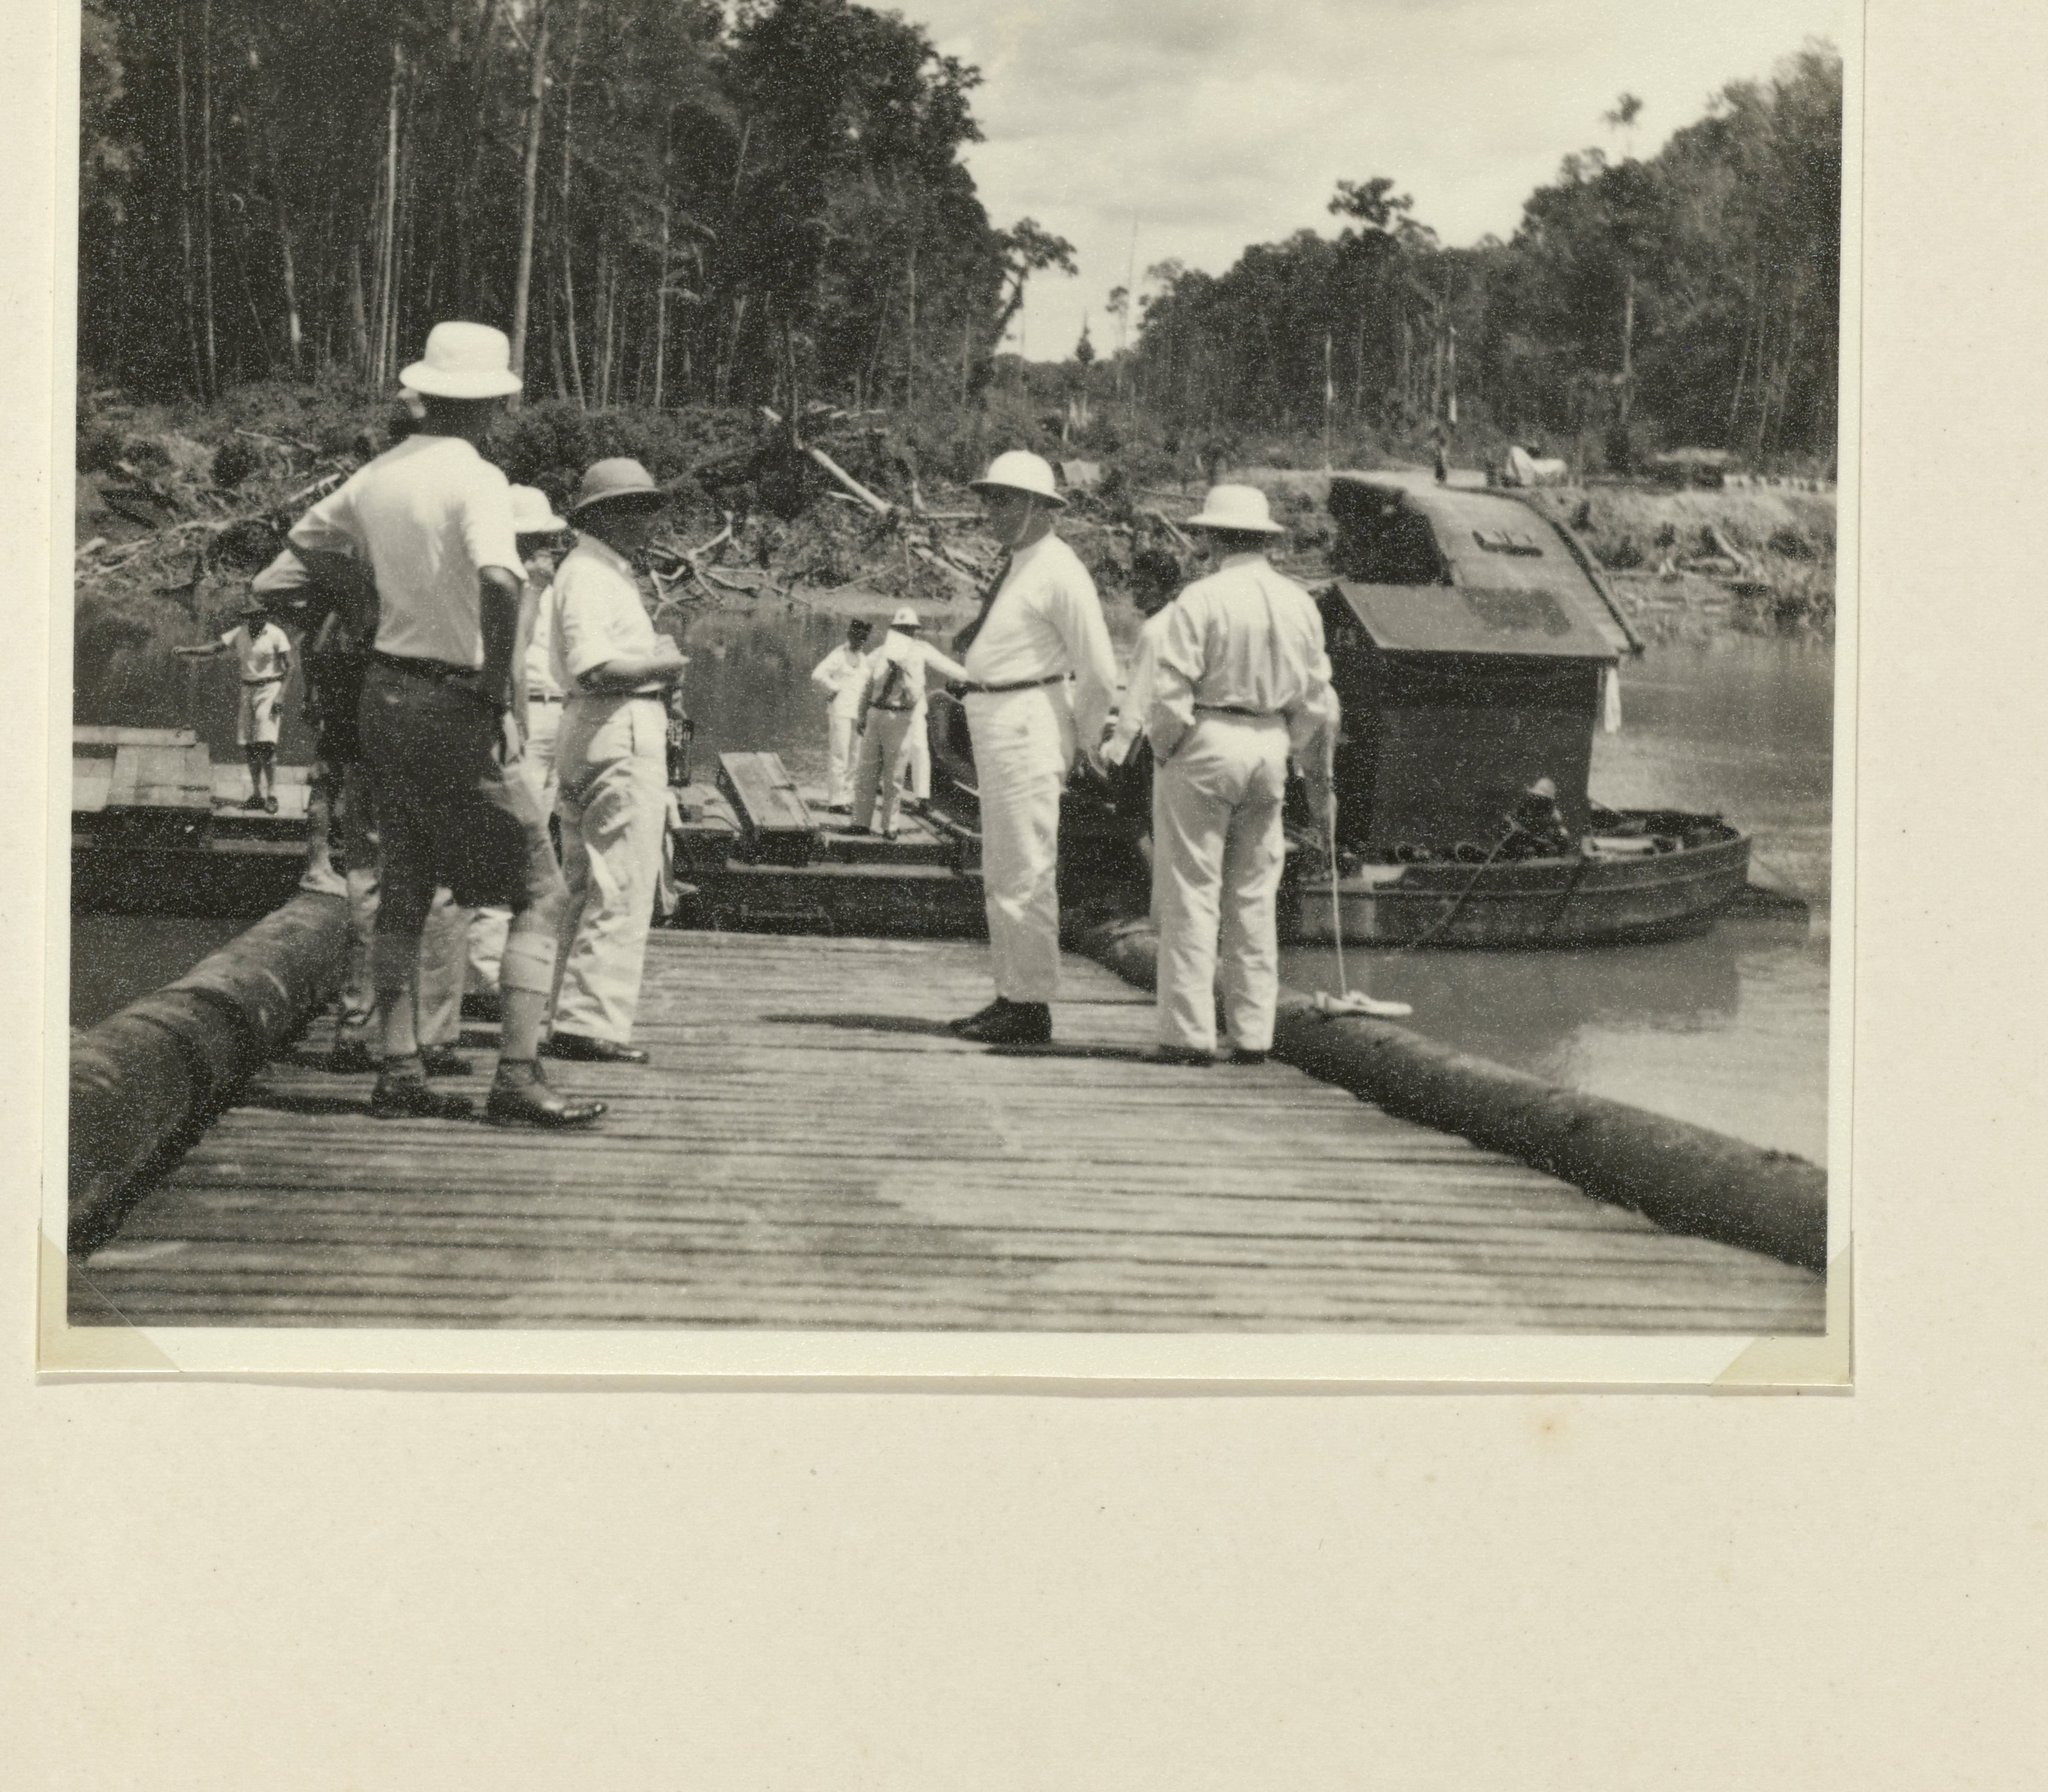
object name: photograph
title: Afrit naar een boot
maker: Anonymous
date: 1935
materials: photographic support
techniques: gelatin silver print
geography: sumatra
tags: utrecht, colonial system, pipeline ~transportation of oil, pier, quay, wharf, commemoration, jubilee, sumatra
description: Enkele mannen op de afrit naar de boot waarmee twee auto's de rivier zijn overgestoken, op de achtergrond een gerooide helling. Foto in het fotoalbum samengesteld ter gelegenheid van de feestelijke ingebruikstelling van de pijpleiding van Tempino naar Pladjoe op Sumatra door de Nederlandsch-Indische Aardolie Maatschappij (NIAM) op 15 november 1935.